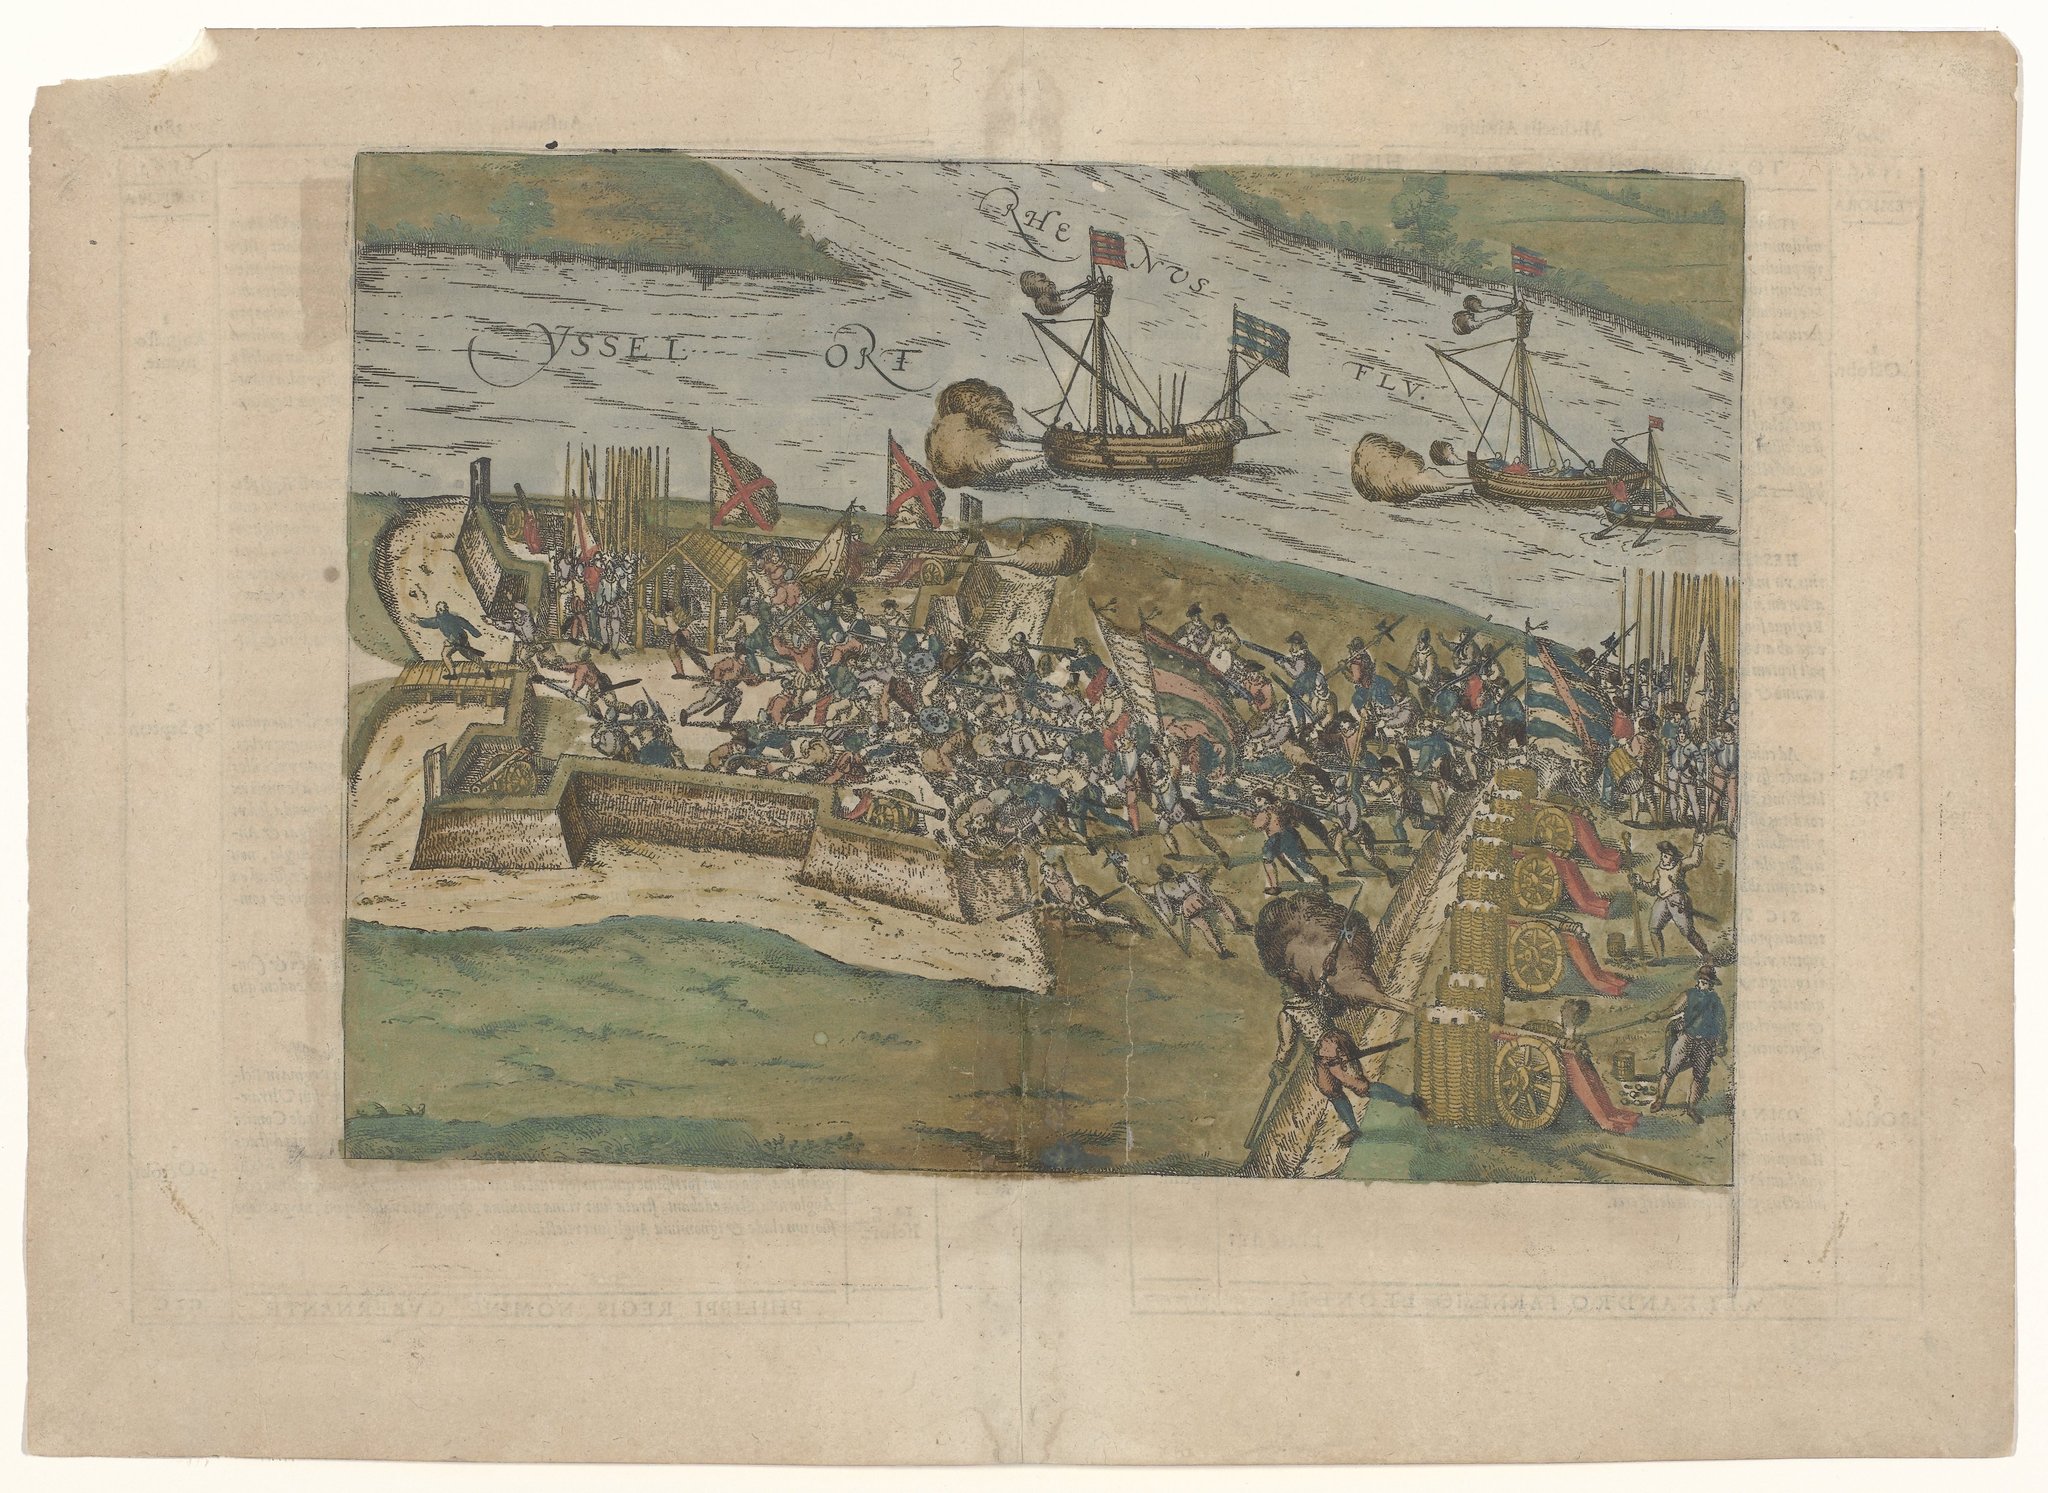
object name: print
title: Serie 9: Nederlandse en Duitse Gebeurtenissen, 1583-1587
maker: frans hogenberg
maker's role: print maker, publisher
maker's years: 1538-1590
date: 1588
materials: paper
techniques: etching, hand coloring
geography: cologne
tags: capture of city (after the siege)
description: Verovering van de schans IJsseloord bij Arnhem, 10 november 1585, door Engelse en Duitse soldaten van het Staatse leger. Op de achtergrond de splitsing van de Rijn en de IJssel. Gedrukt met een cache over het onderschrift.